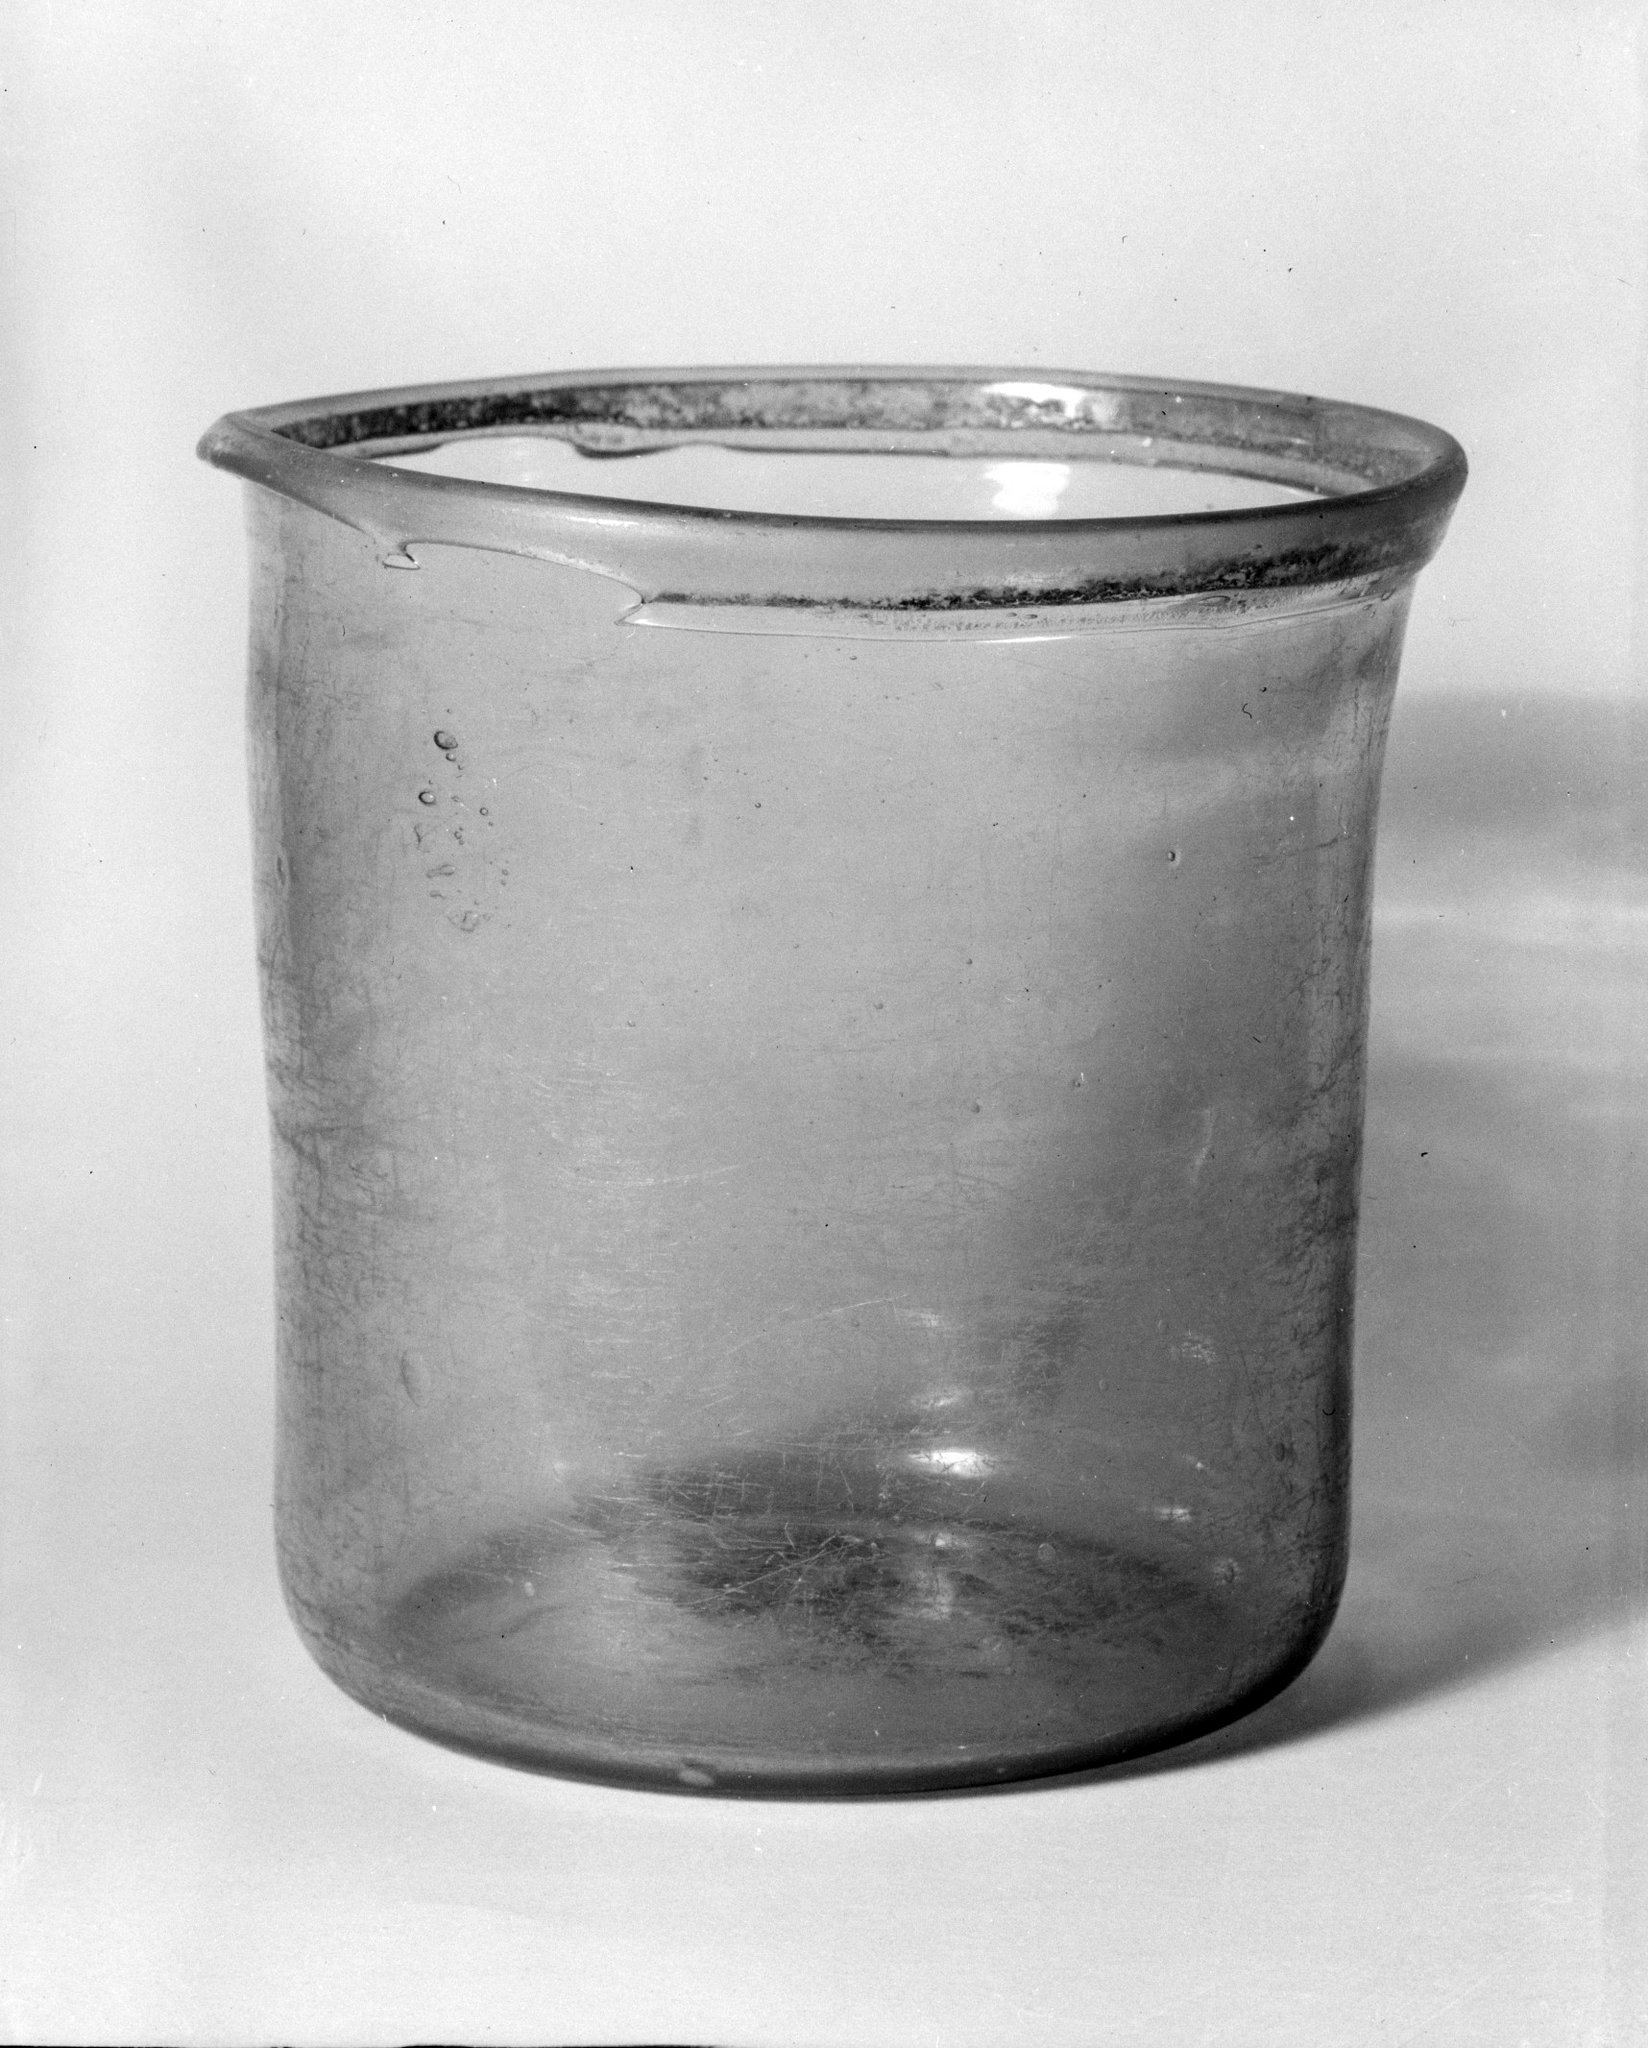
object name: bowl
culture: american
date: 1701-1800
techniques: glassblowing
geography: united states